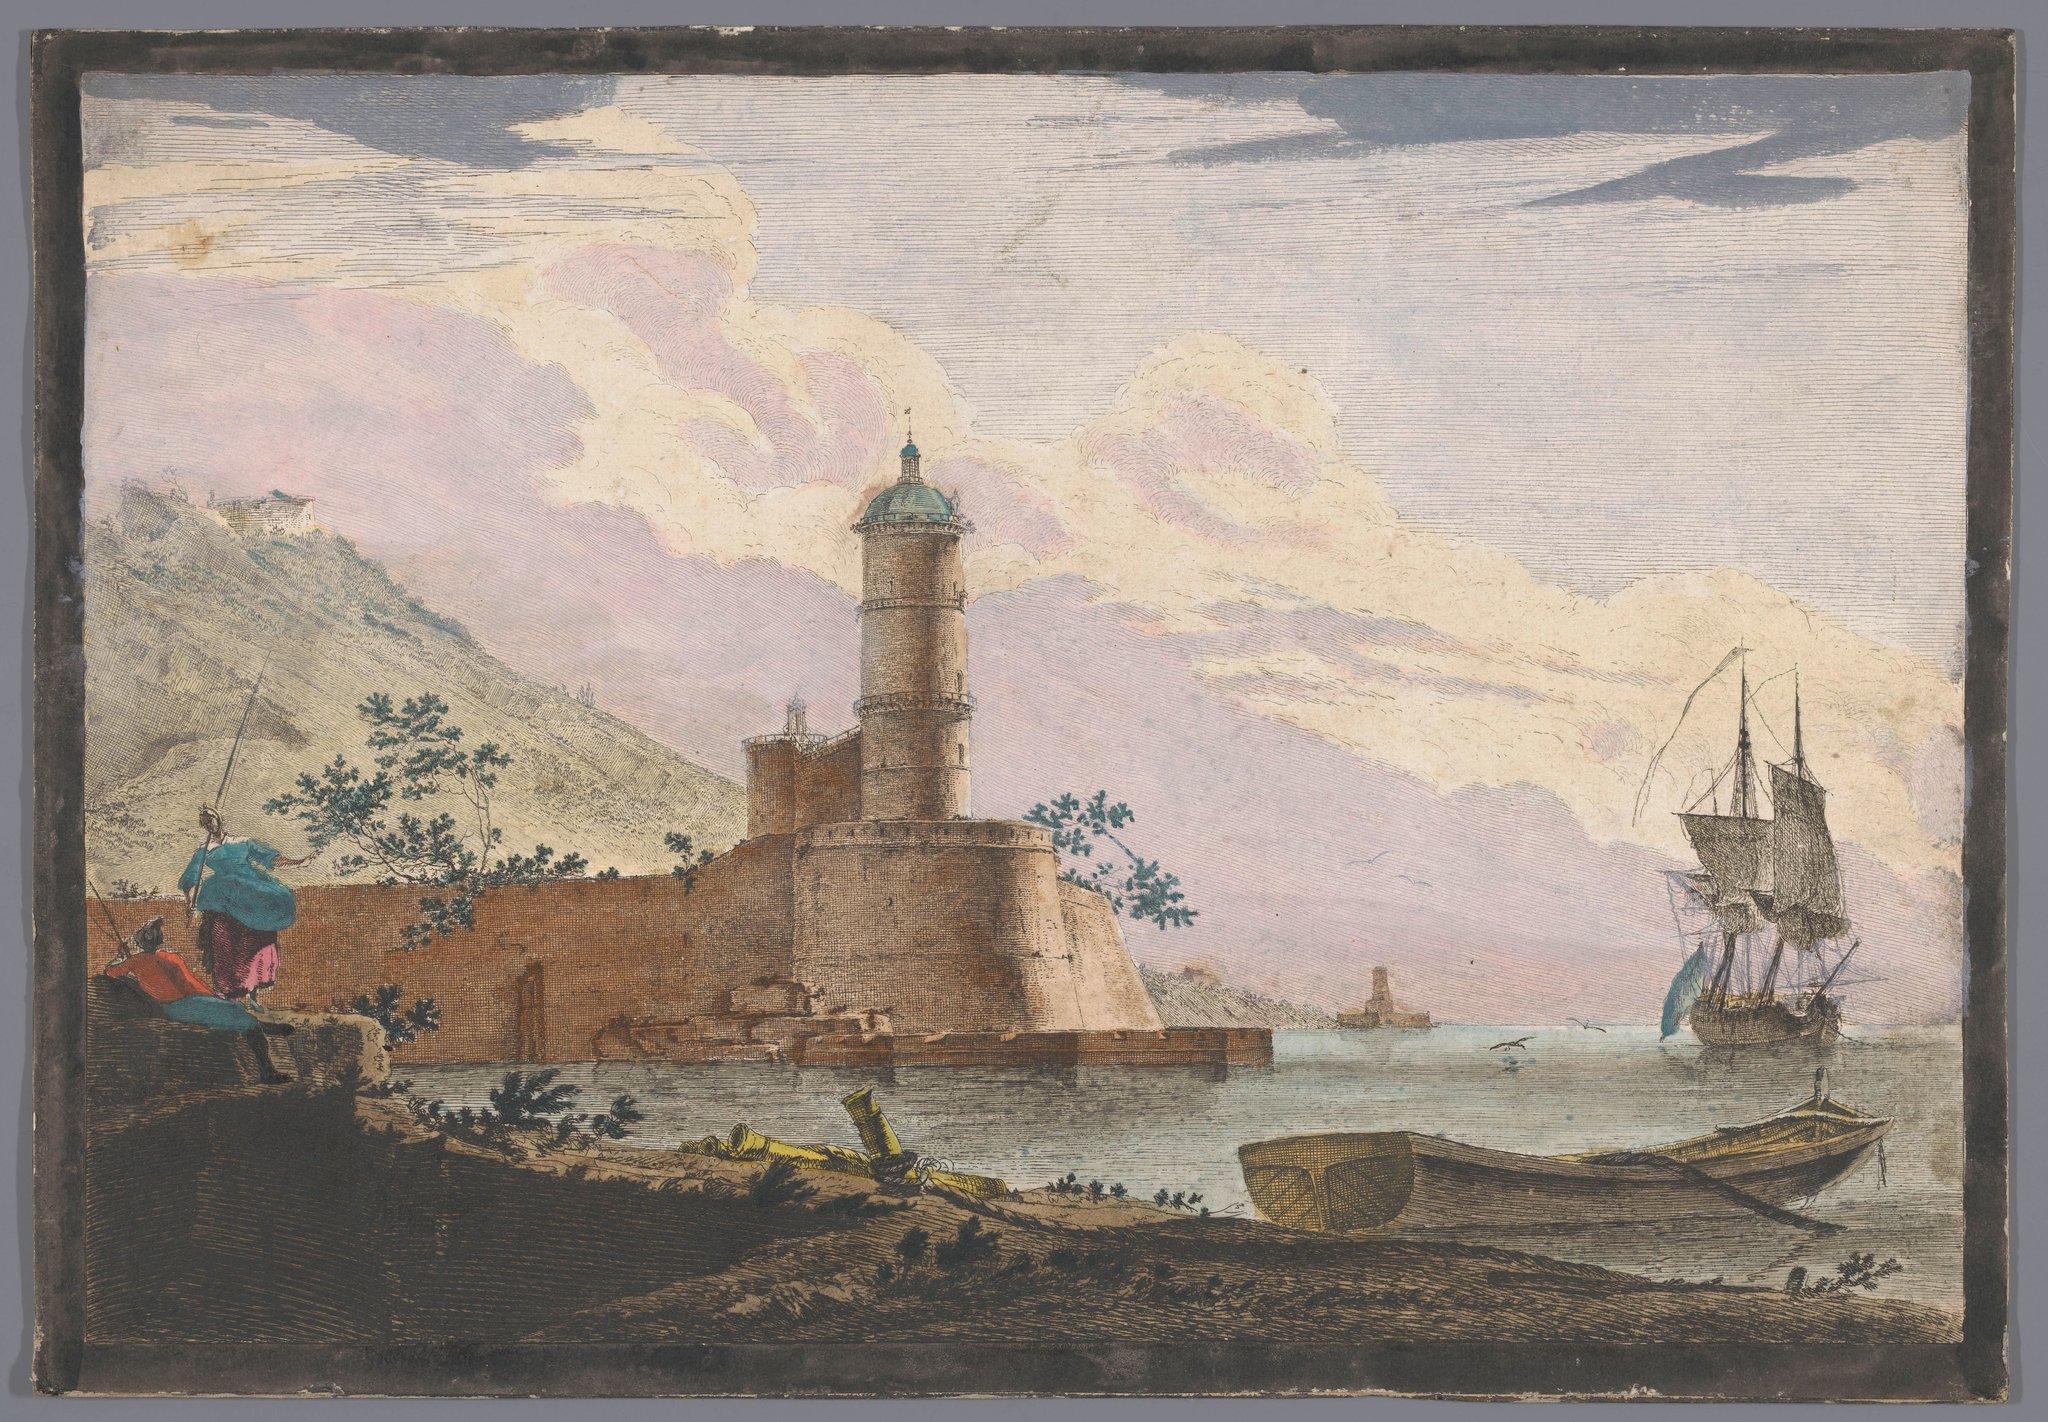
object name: opticaprent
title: Gezicht op een haven met een toren aan de waterkant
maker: Anonymous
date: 1700-1799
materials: cardboard, paper, watercolor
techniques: brush, etching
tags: harbour, sailing-ship, sailing-boat, tower, clock tower ~ monumental adornment, rowing-boat, canoe, etc., sea (seascape) (+ landscape with figures, staffage)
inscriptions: collector's mark: Lugt 2233